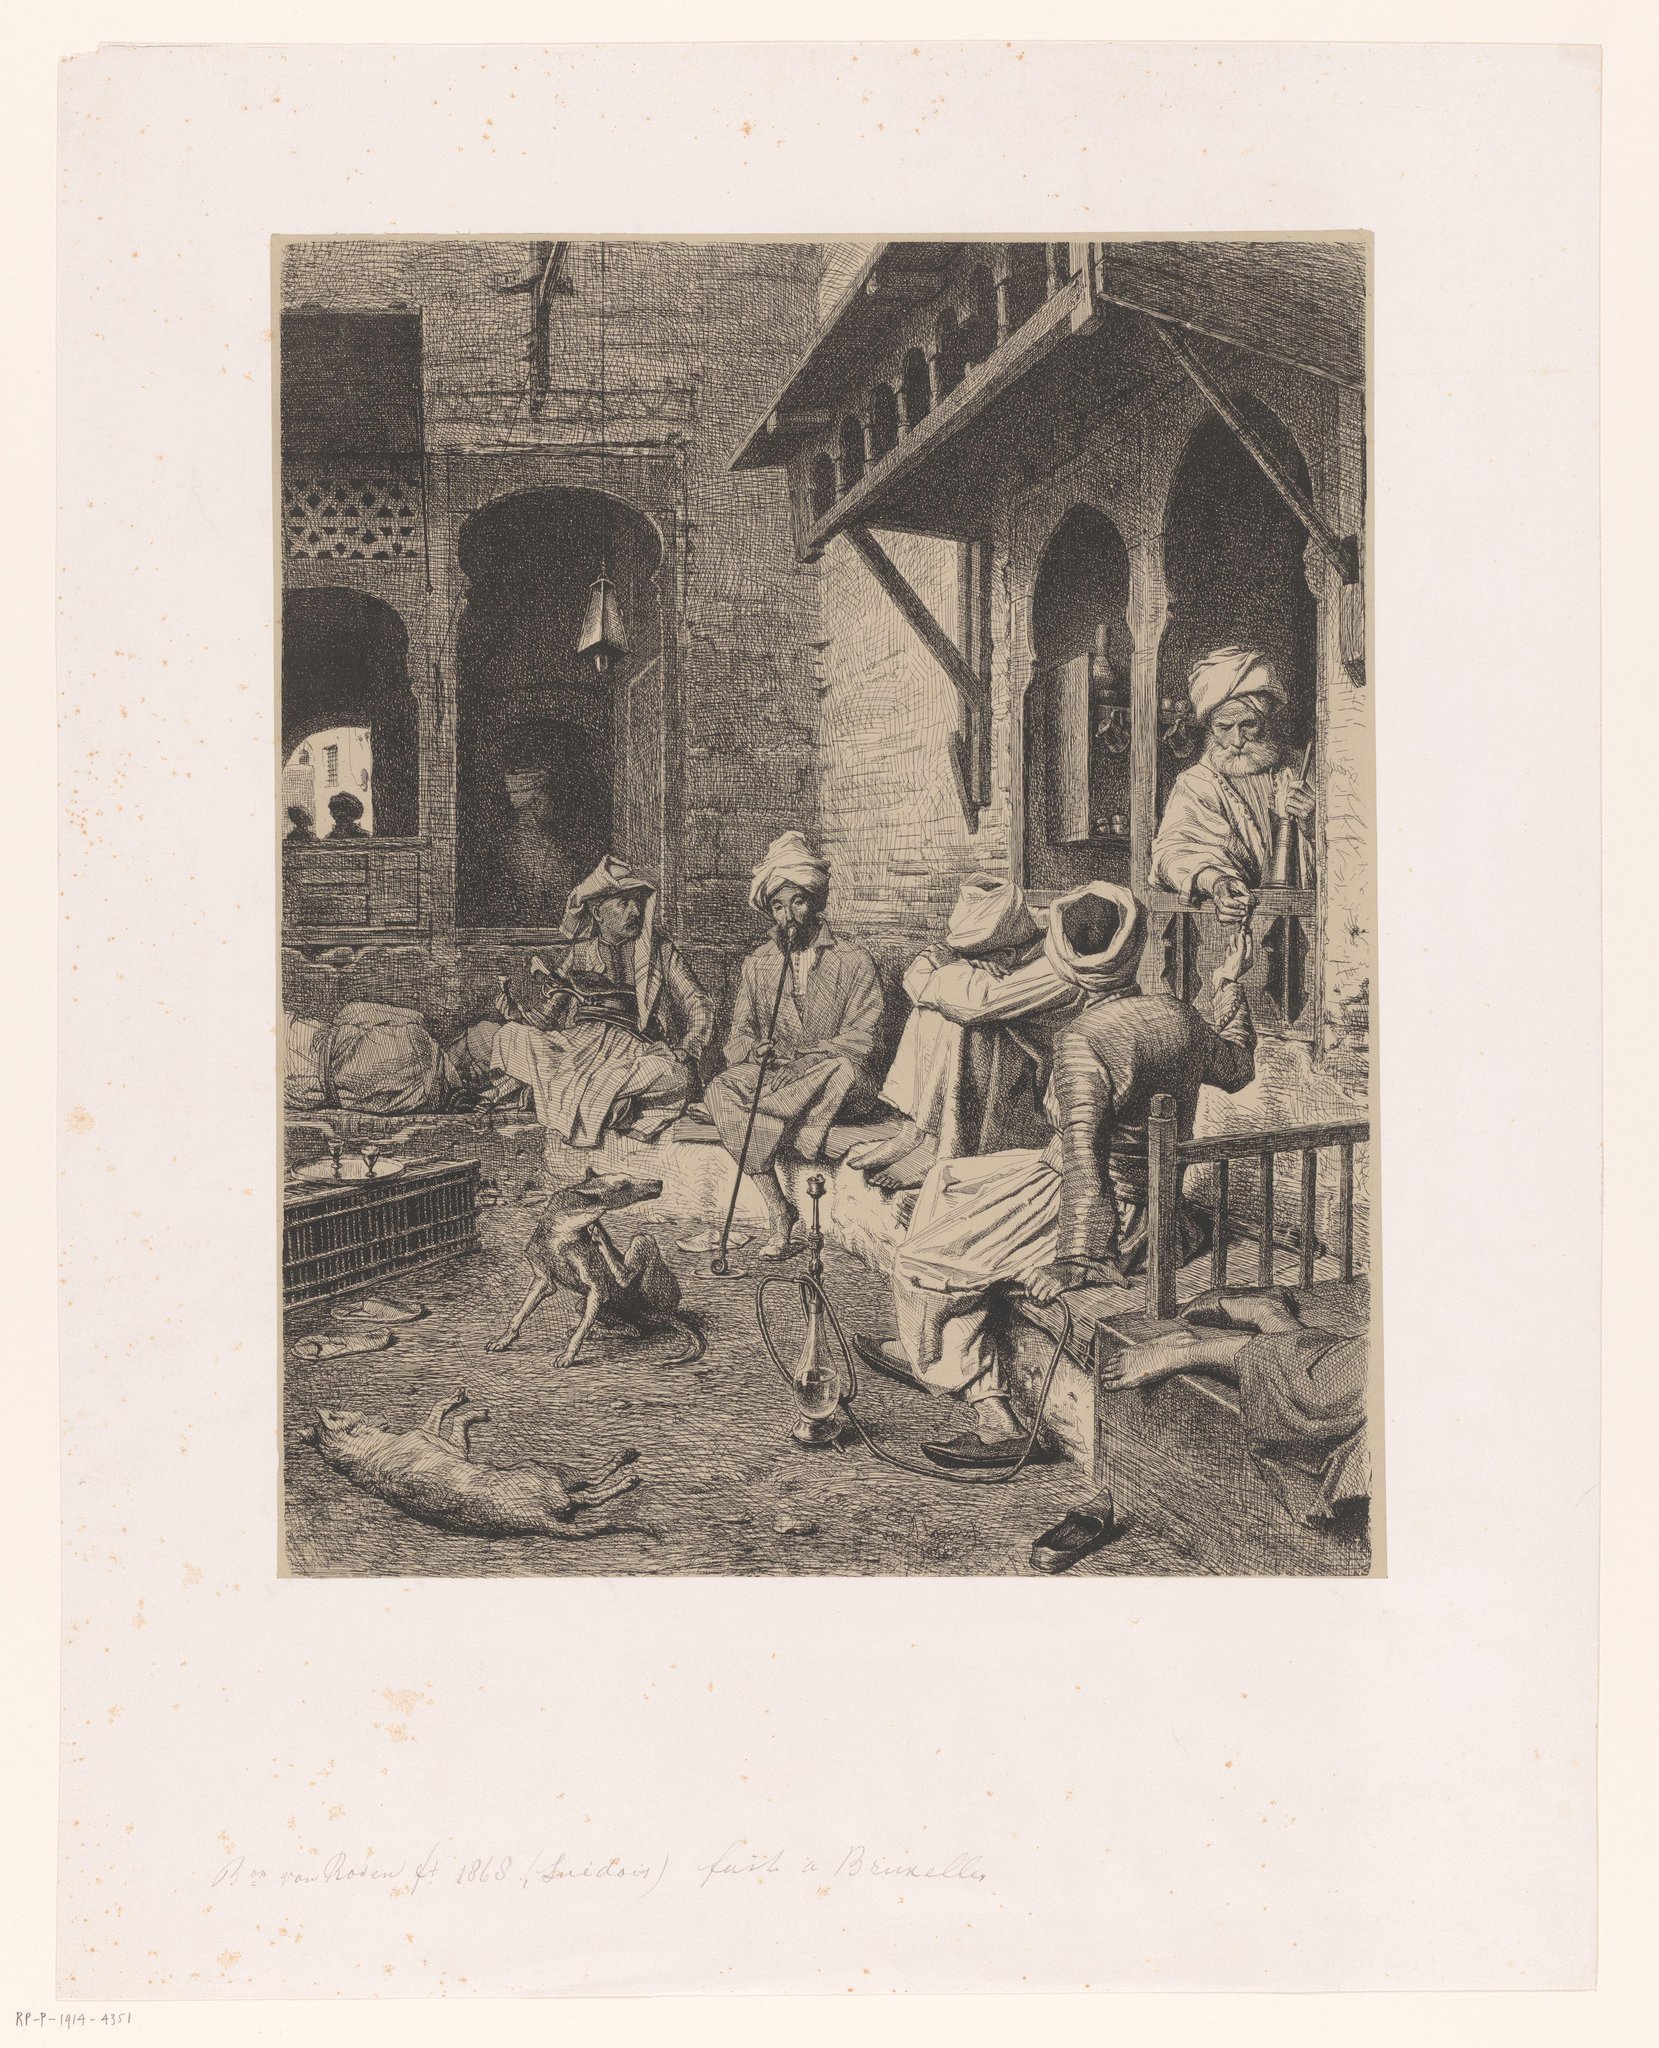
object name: print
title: Rokende Turkse mannen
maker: johan georg otto graf von rosen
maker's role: print maker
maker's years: 1843-1923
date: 1868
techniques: printmaking, etching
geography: brussels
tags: water-pipe, hookah, narghile, pipe ~ tobacco, courtyard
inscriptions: annotation: ‘B.on von Rosen ft. 1868 (Suédois) fait a Bruxelles’, collector's mark: Lugt 2228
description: Gezicht in een binnenplaats met een aantal rokende Turkse mannen. Op de grond liggen twee honden.